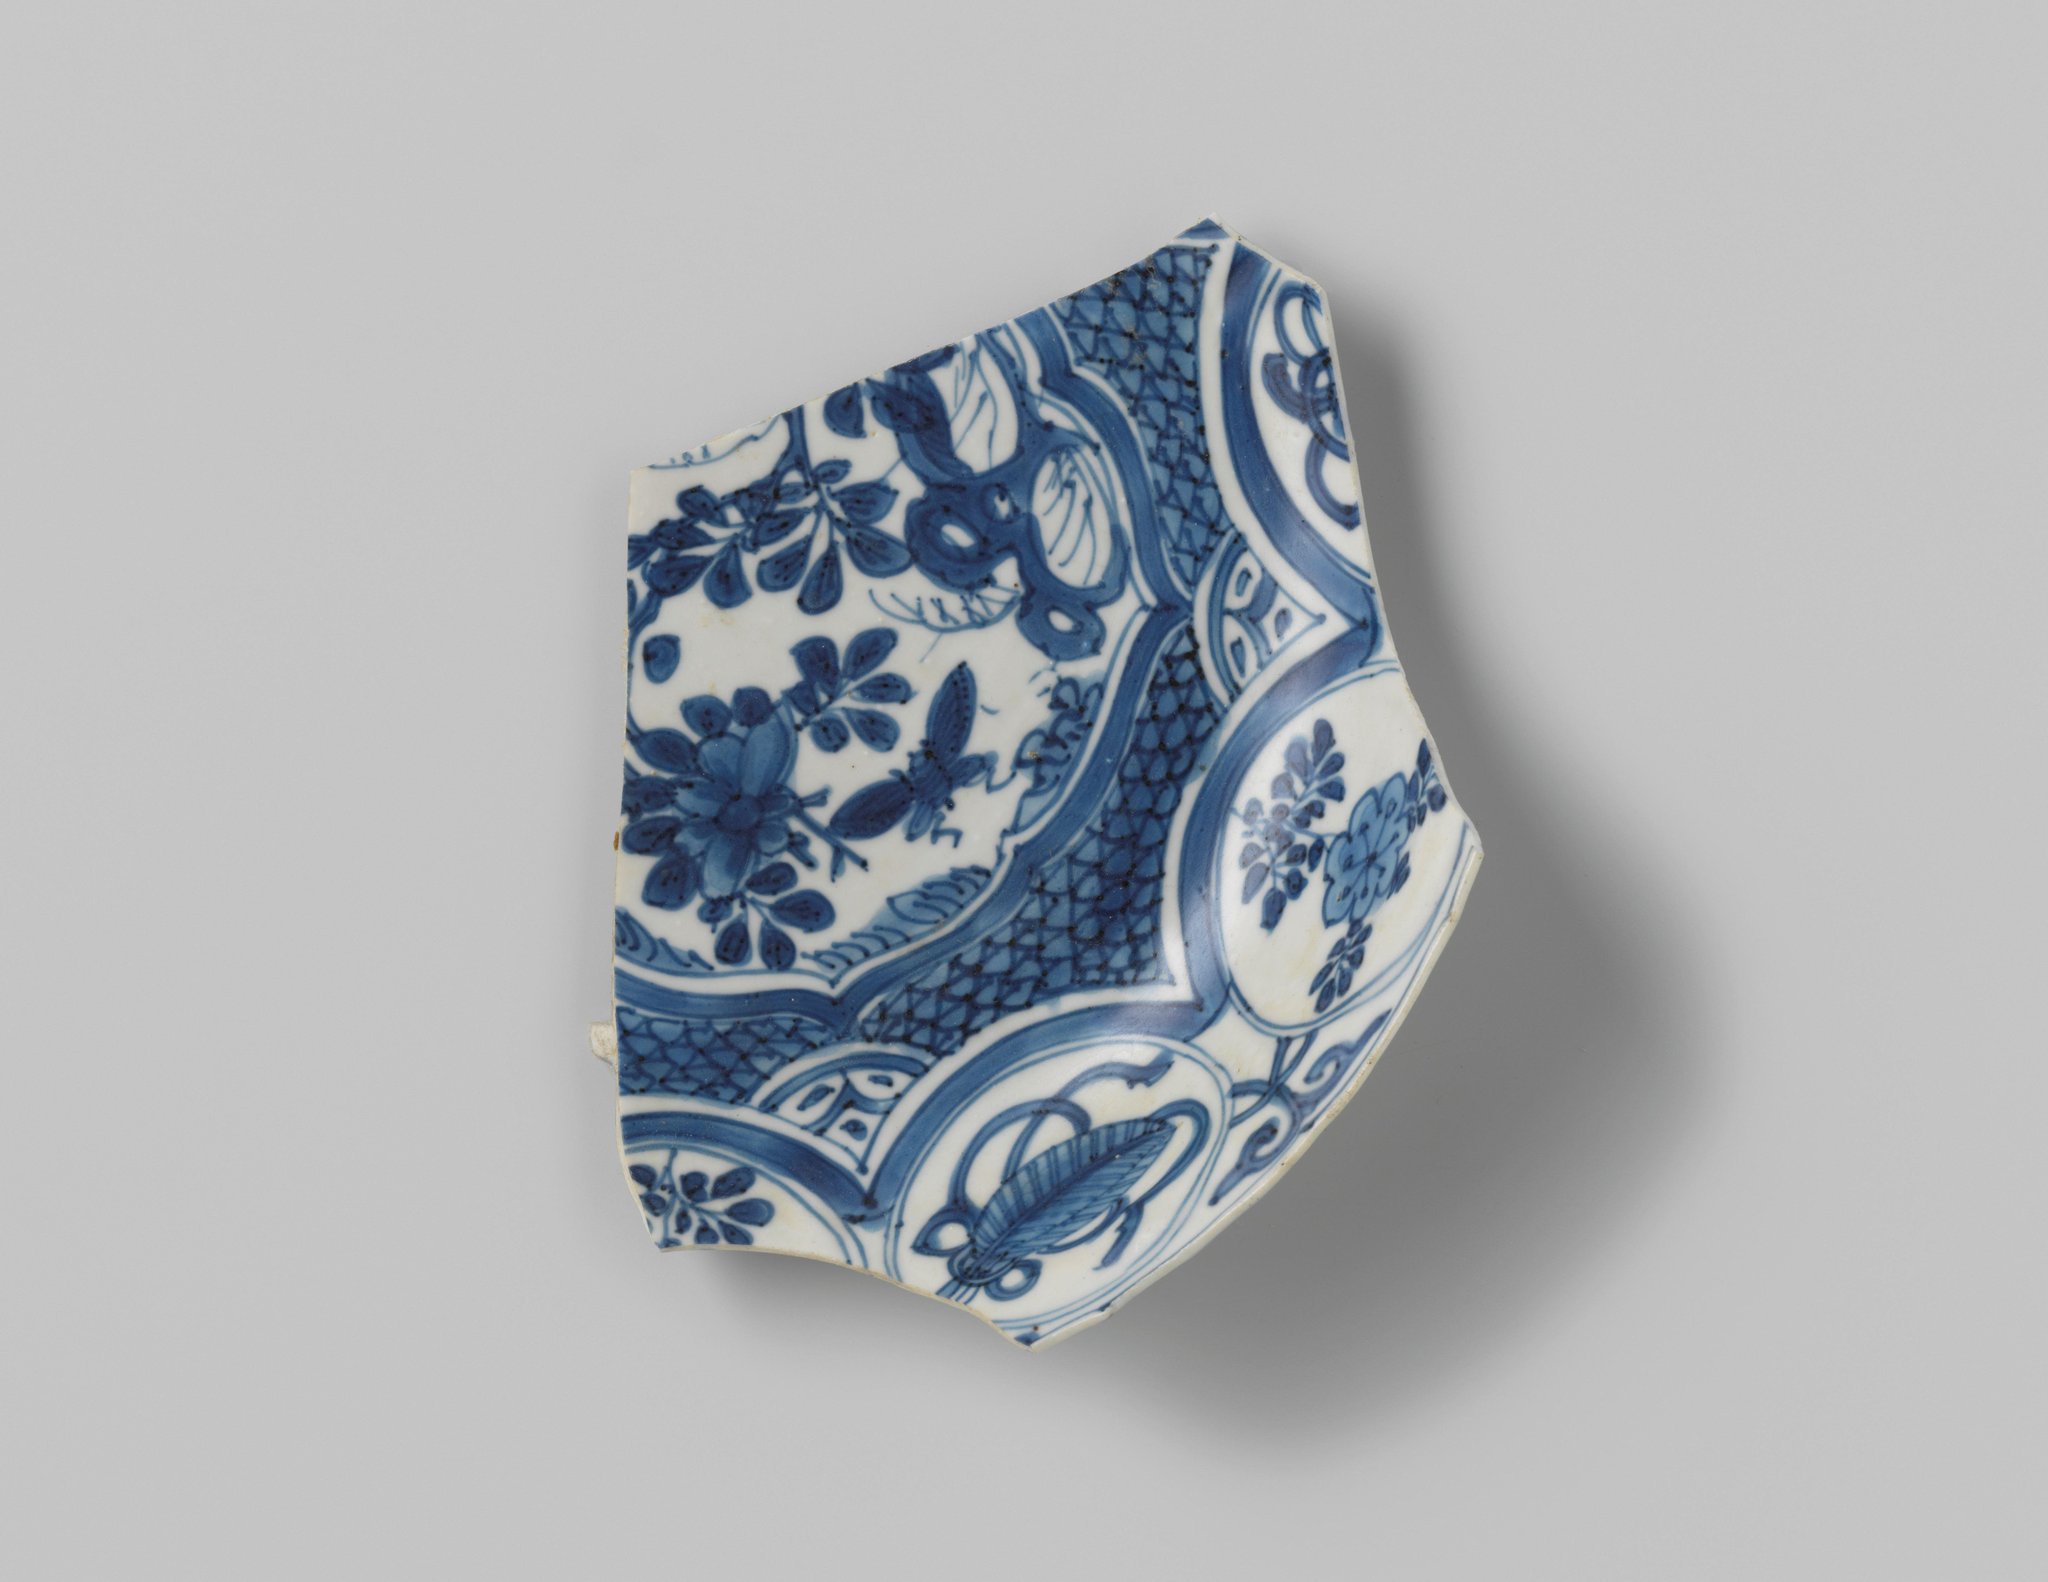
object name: sherd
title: Fragment bord uit V.O.C.-schip de 'Witte Leeuw'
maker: Anonymous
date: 1613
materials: bone china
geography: jingdezhen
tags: verenigde oostindische compagnie, sint-helena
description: A dish without a flattened rim. A scalloped medallion with 5 rui heads within a star-shaped medallion, filled with various diaper patterns. A central decoration of a flying insect near a flower on a rock The encircling medallion has a diaper pattern of triangles. The medallions decorated with a flower and a symbol.